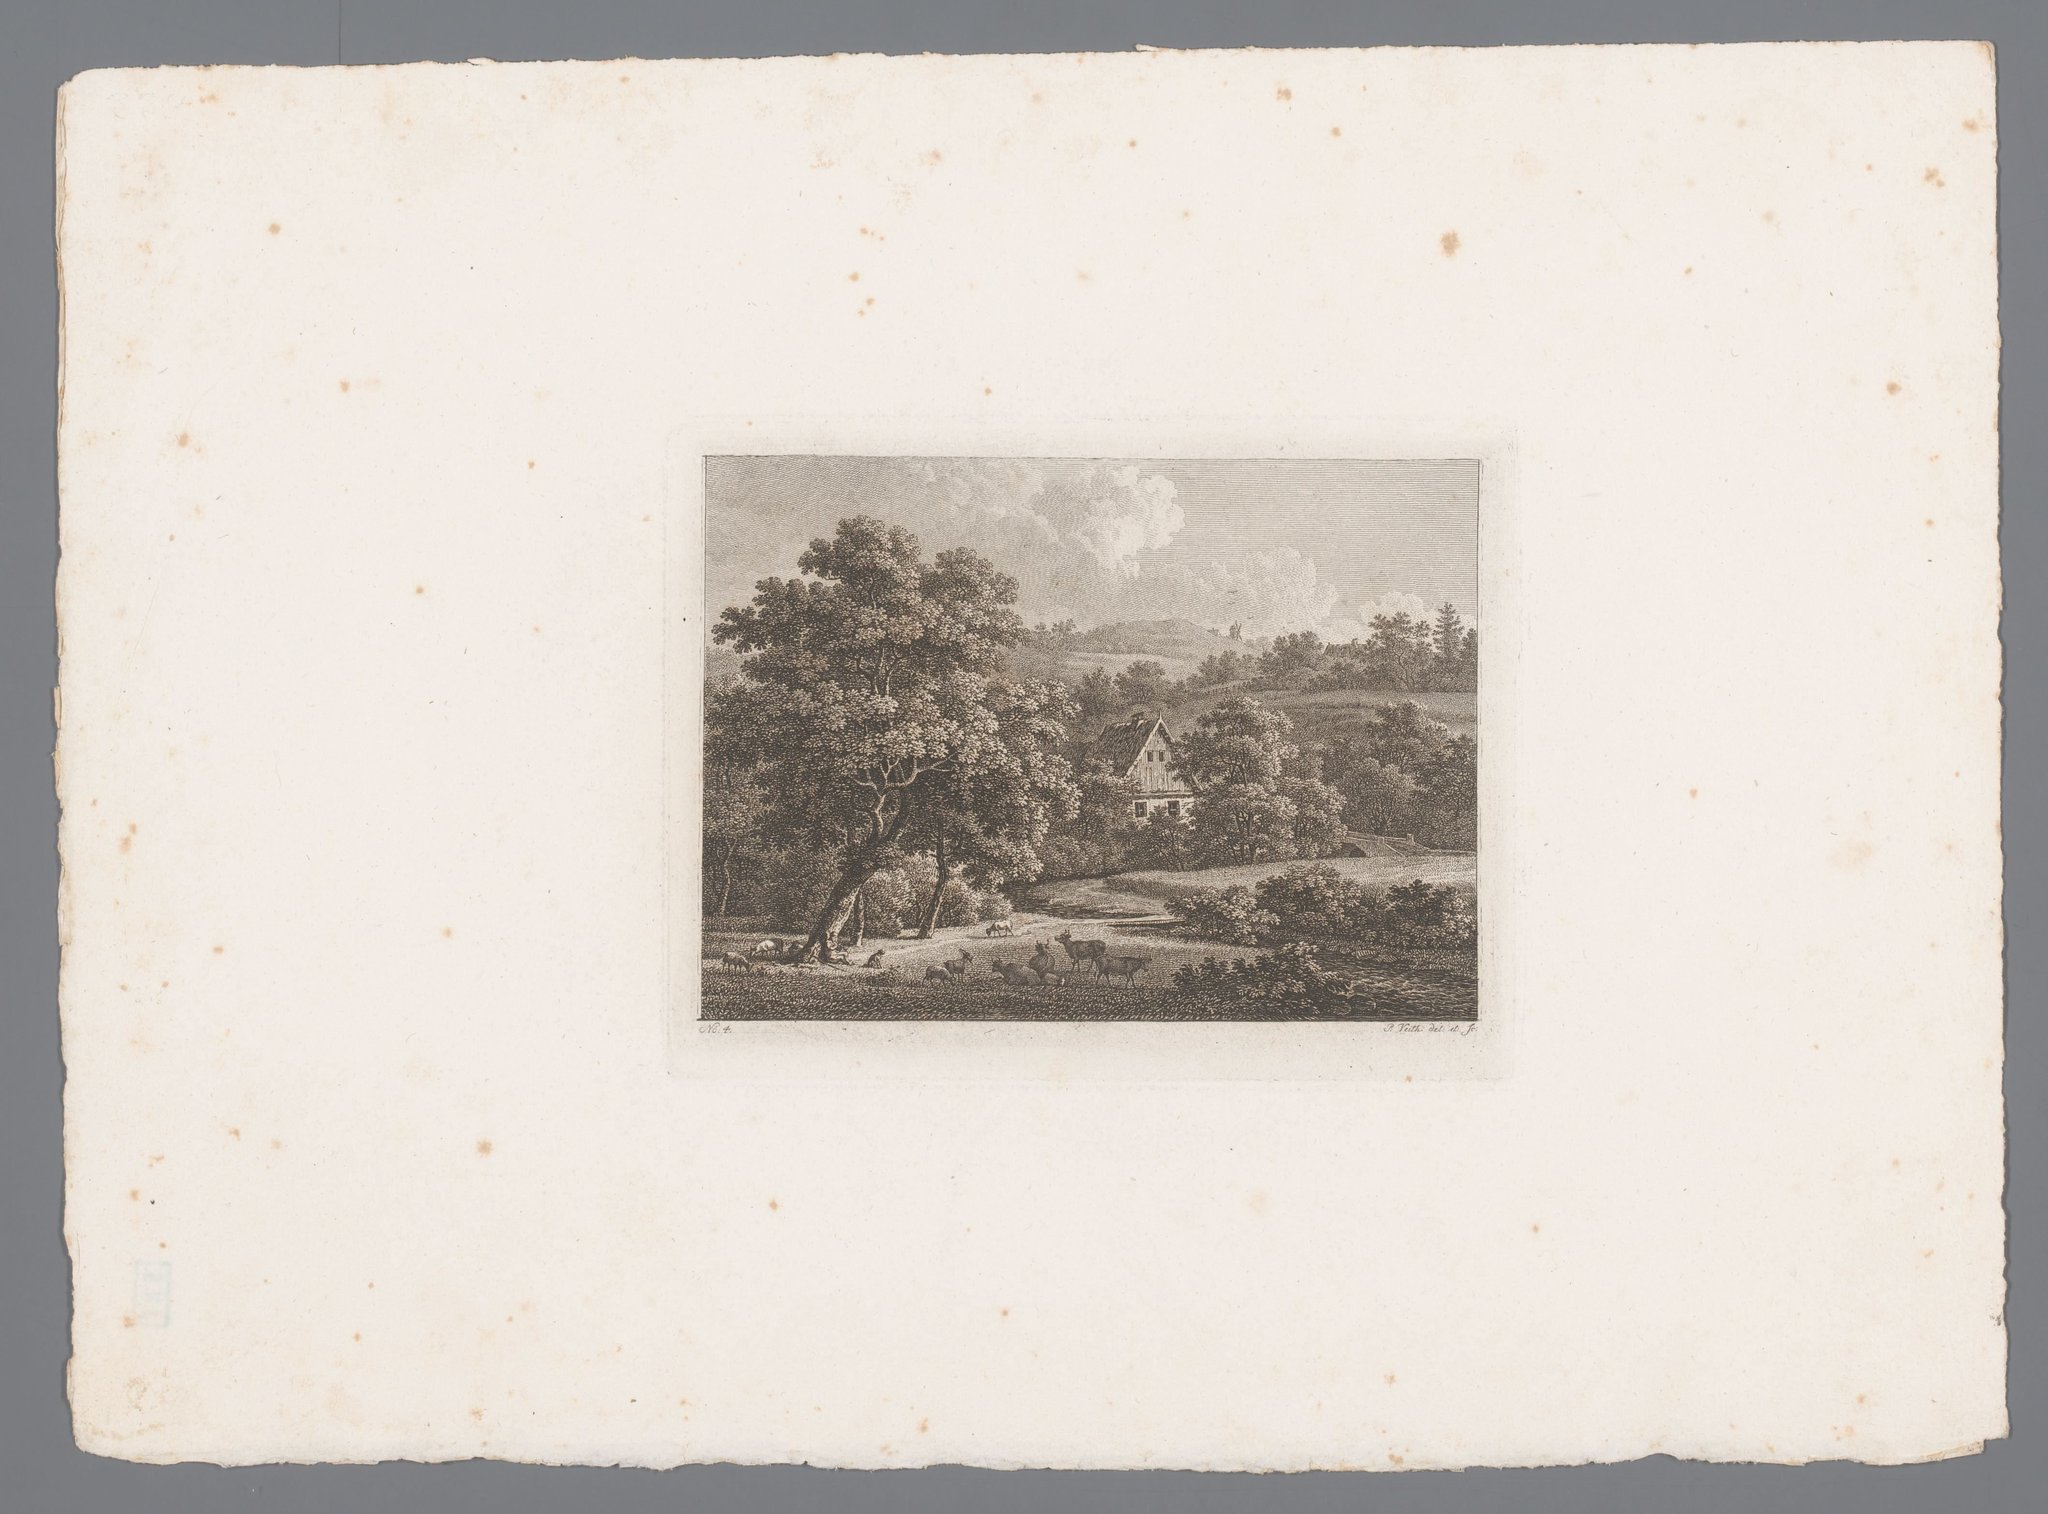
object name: print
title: Landschap met een kudde vee en een herder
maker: philipp veith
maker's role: draughtsman, print maker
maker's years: 1768-1837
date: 1822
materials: paper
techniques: etching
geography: dresden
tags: landscapes, herding, herdsman, herdswoman, shepherd, shepherdess, cowherd, etc.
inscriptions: collector's mark: Lugt 3976, collector's mark: Lugt 2228, collector's mark: Lugt 2760